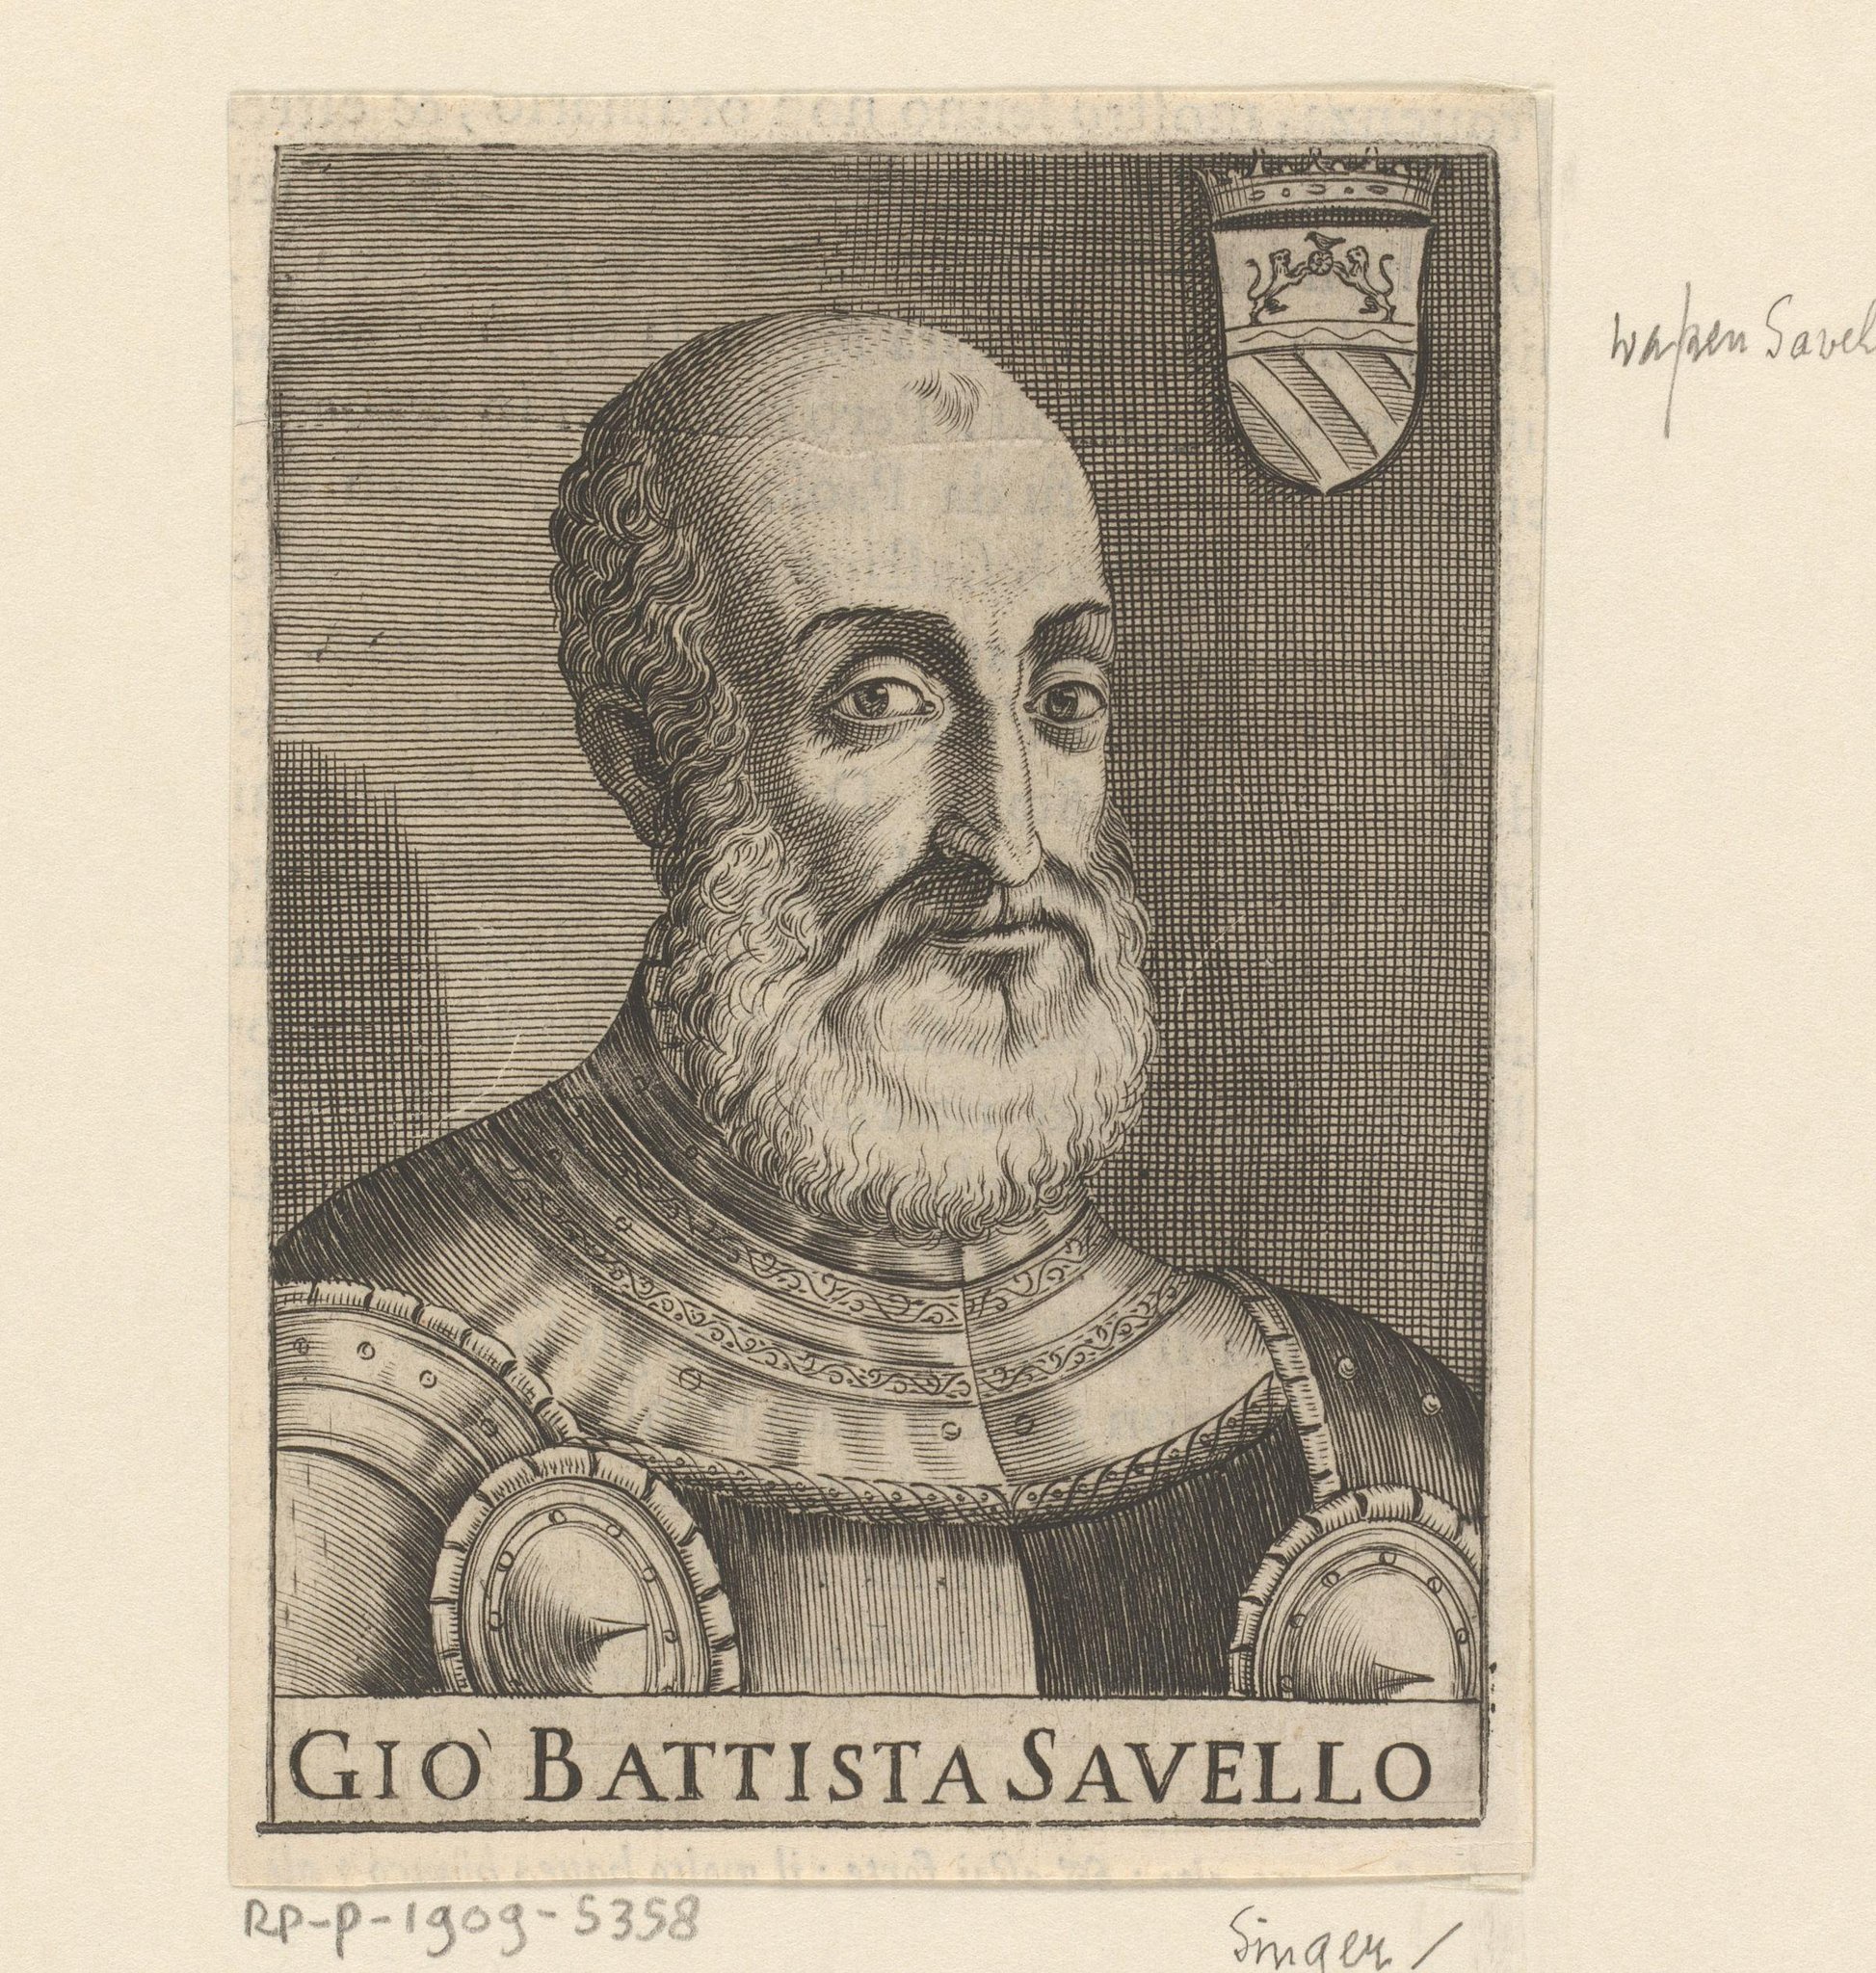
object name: print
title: Portret van Giovan Battista Savello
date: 1646-1647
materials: paper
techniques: engraving, letterpress printing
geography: rome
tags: ranks in the army, historical persons, armorial bearing, heraldry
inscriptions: collector's mark: Lugt 2228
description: Prent uit: Ritratti et elogii di capitani Illustri. Che ne'secoli moderni hanno gloriosamente guerreggiato. Rome: Filippo de'Rossi en Vitale Mascardi, 1646, p. 300. Prent ook gebruikt in dezelfde editie van 1647. Eerdere staat van prent in ieder geval ook gebruikt in: Ritratti et elogii di capitani Illustri. Rome: Pompilio Totti en Andrea Fei, 1635.